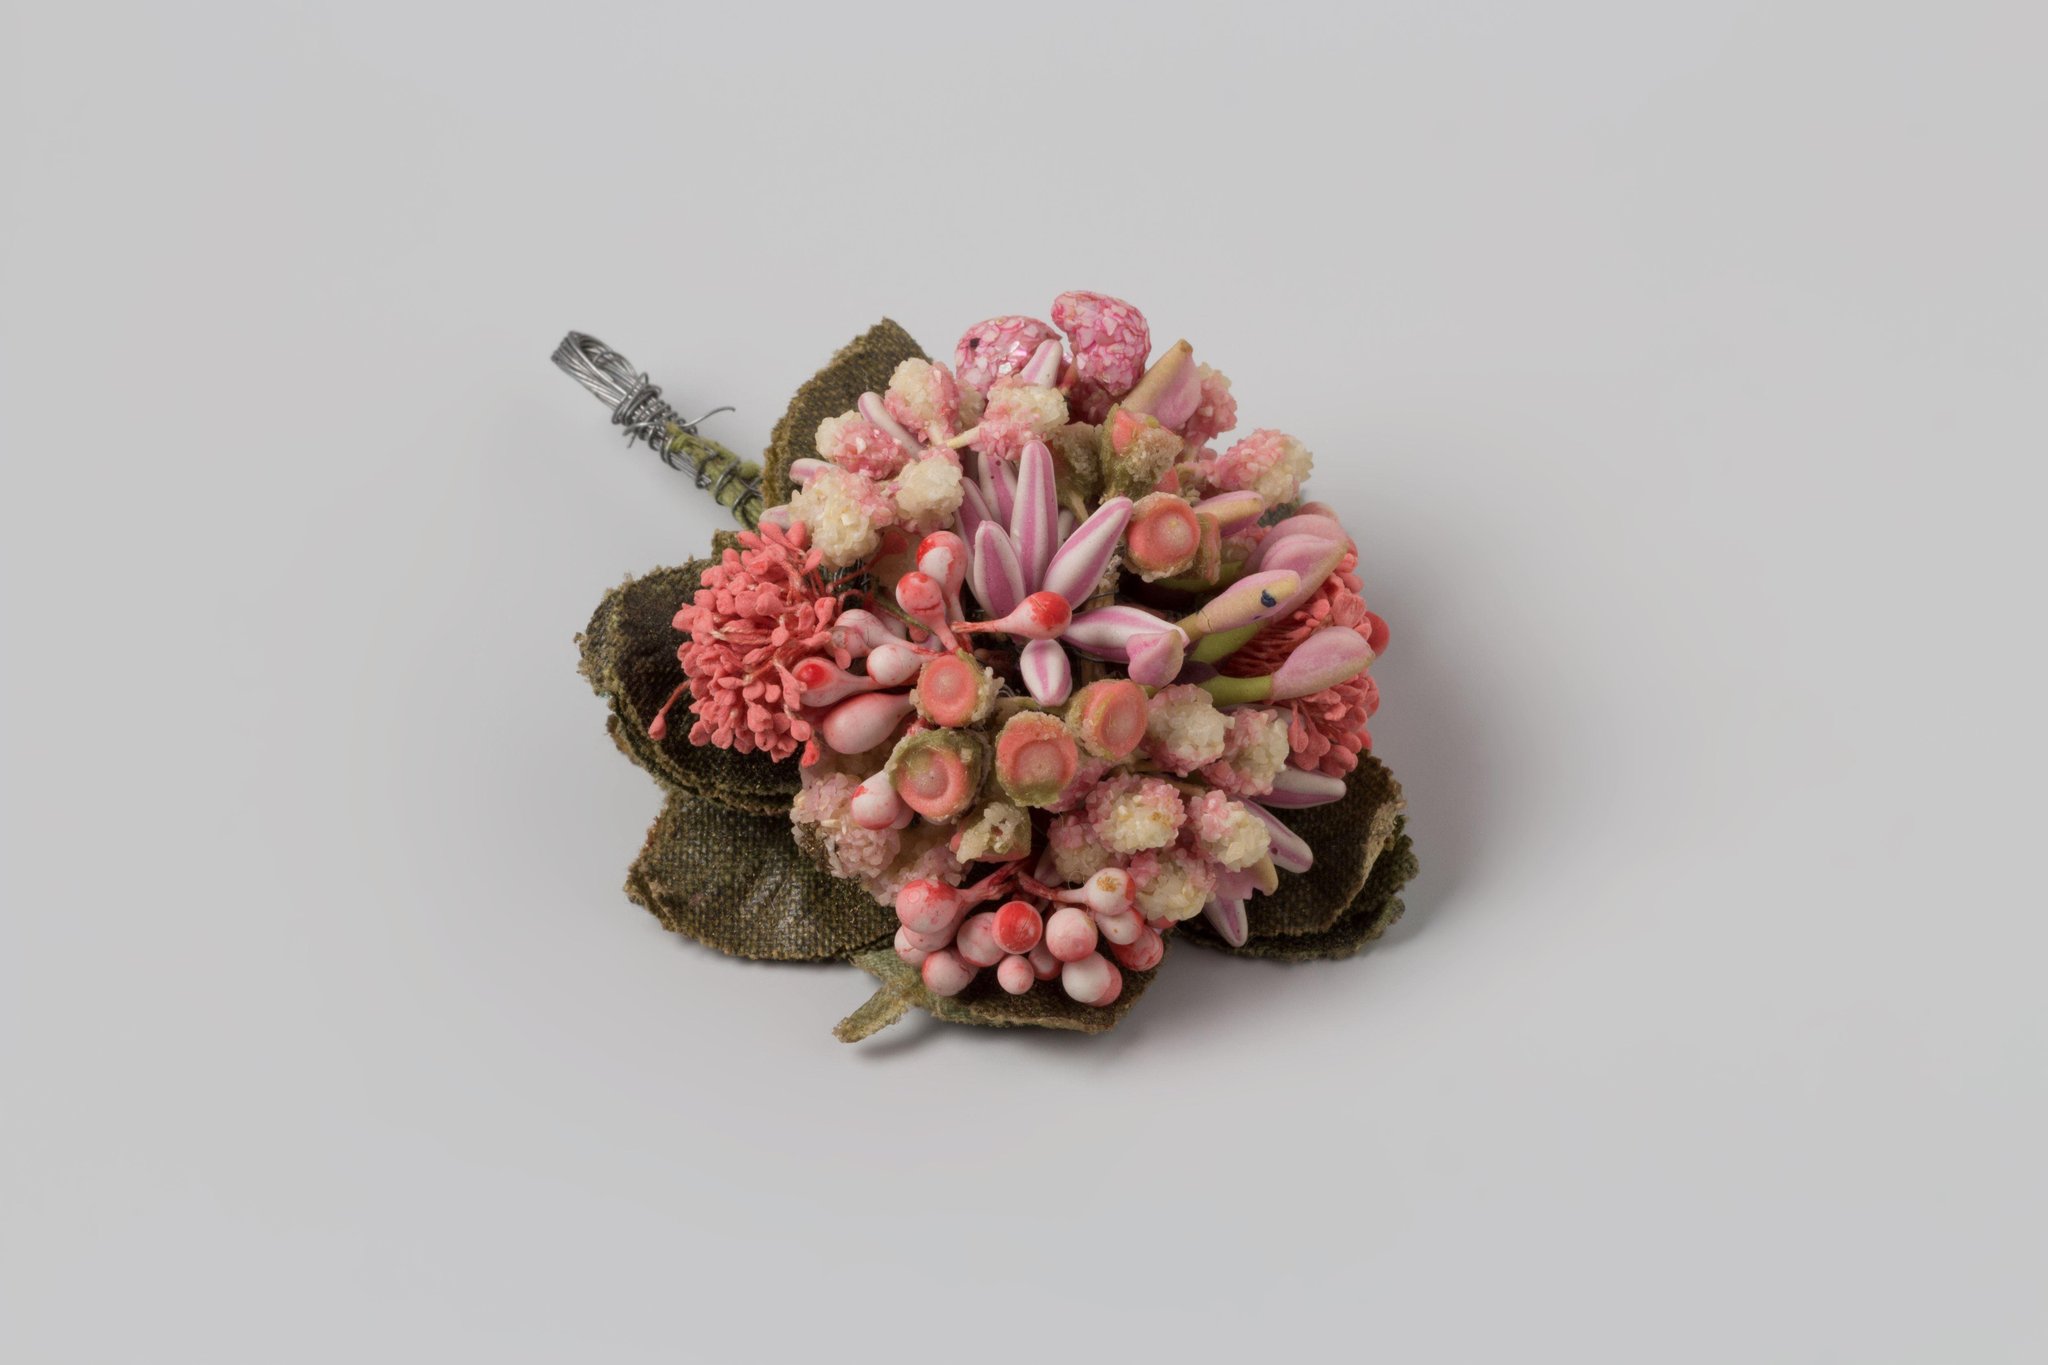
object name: corsage costume accessory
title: Corsage met op steeltjes staande stampers en meeldraden in rose, wit en lila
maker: Anonymous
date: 1900-1950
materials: plastic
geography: netherlands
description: Corsage met op steeltjes staande stampers en meeldraden in rose, wit en lila, in acht verschillende vormen.